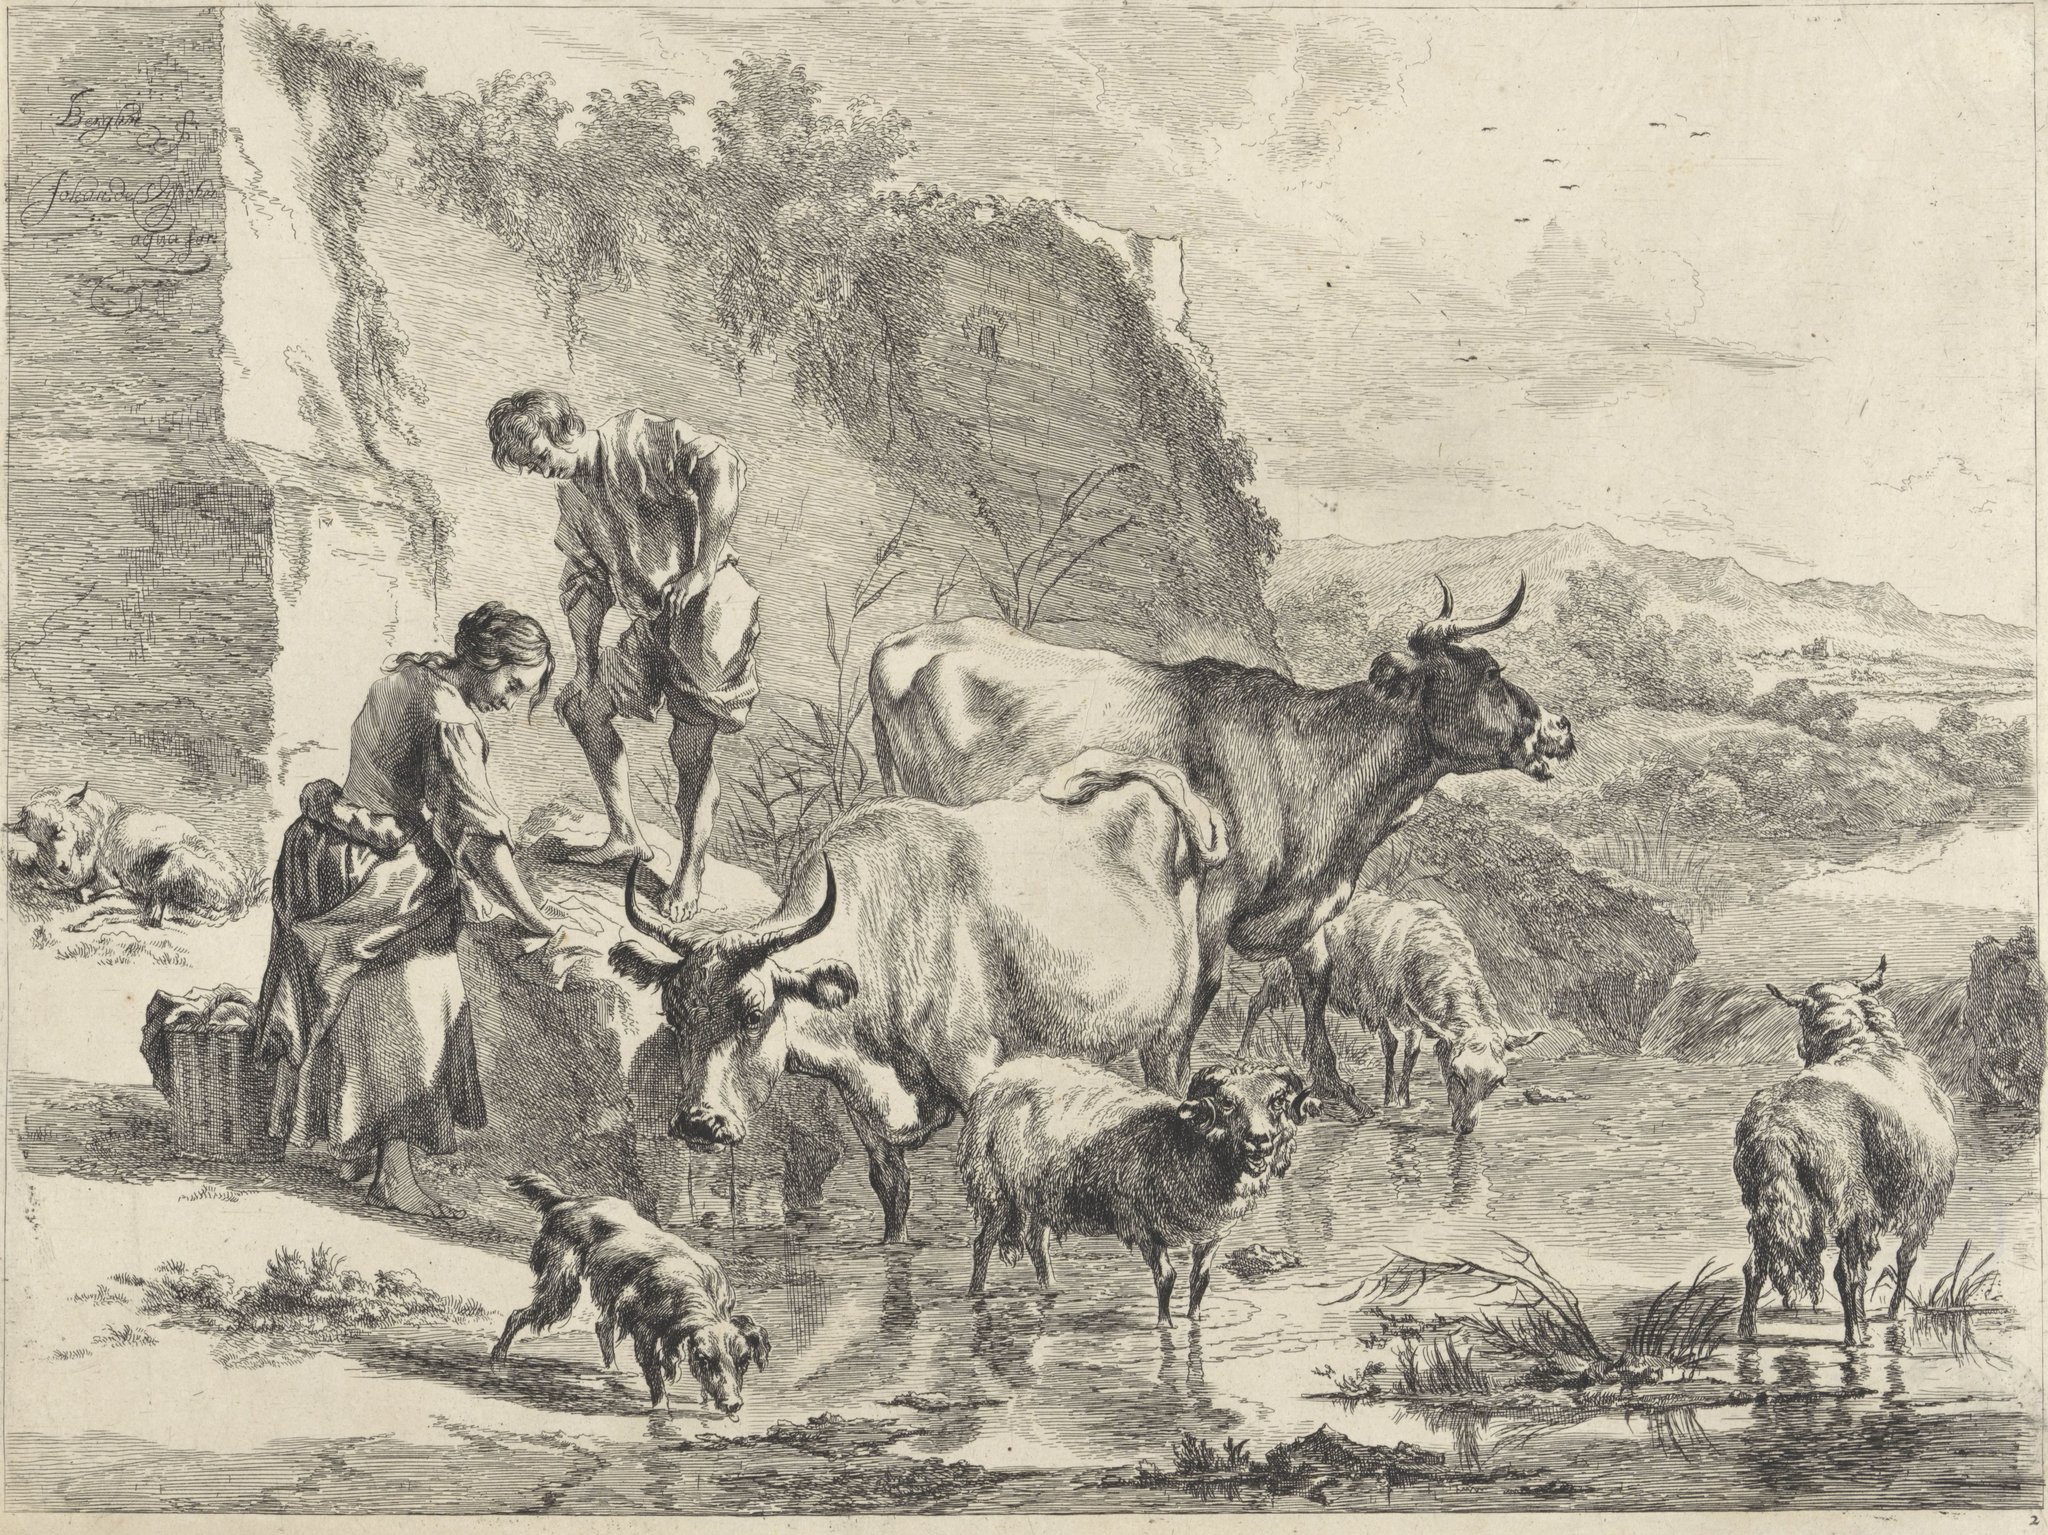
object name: print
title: Landschappen met viervoeters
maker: jan de visscher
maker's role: print maker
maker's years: 1633-1712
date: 1657-1706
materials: paper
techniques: engraving, etching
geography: northern netherlands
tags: landscapes, herding, herdsman, herdswoman, shepherd, shepherdess, cowherd, etc., sheep, laundering, dog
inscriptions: collector's mark: Lugt 10, collector's mark: Lugt 11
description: Gezicht op een landschap met op de voorgrond een beek waar een jonge vrouw haar was op een steen te drogen legt. Een herdersjongen staat op de steen en kijkt toe, zijn vee staat in het water. Op de voorgrond een hondje dat water drinkt uit de beek.